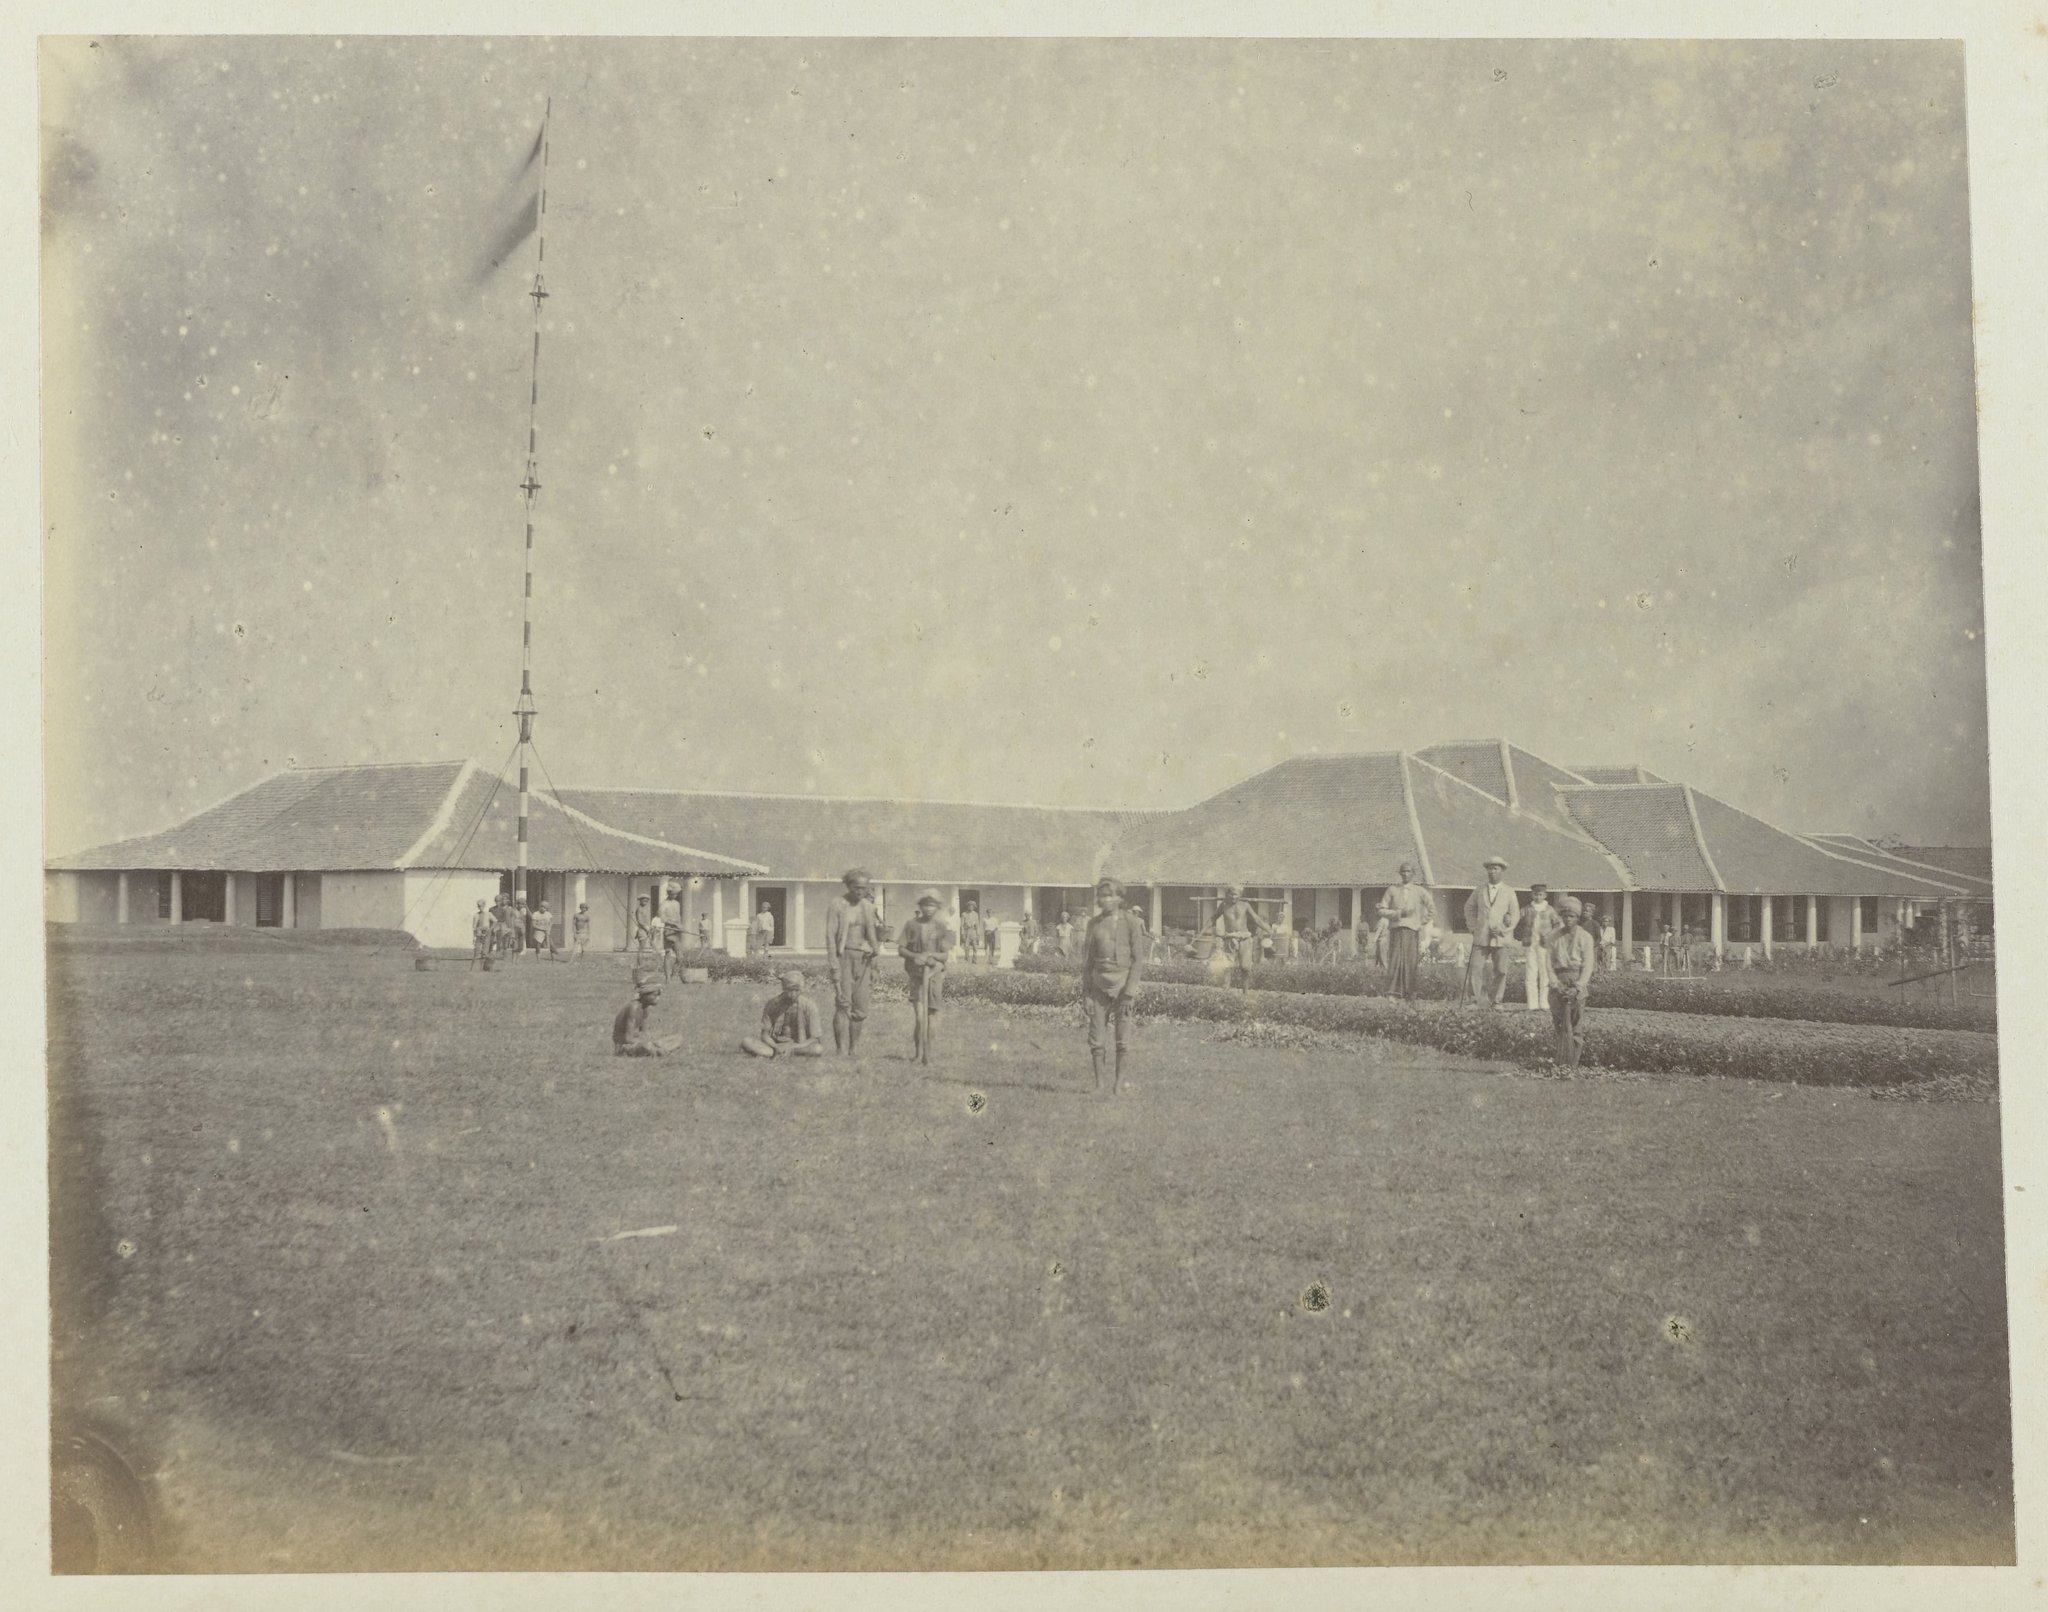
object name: photograph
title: Hoofdgebouw met vlaggenmast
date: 1863-1869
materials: photographic support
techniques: albumen print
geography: java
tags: plantation, java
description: Indische werknemers voor een hoofdgebouw, mogelijk van een onderneming, links een vlaggenmast met de Nederlandse vlag. Onderdeel van het groene fotoalbum met foto's van Java, uit het bezit van apotheker Specht-Grijp, die in 1865 vanuit Batavia naar Nederland terugkeerde.